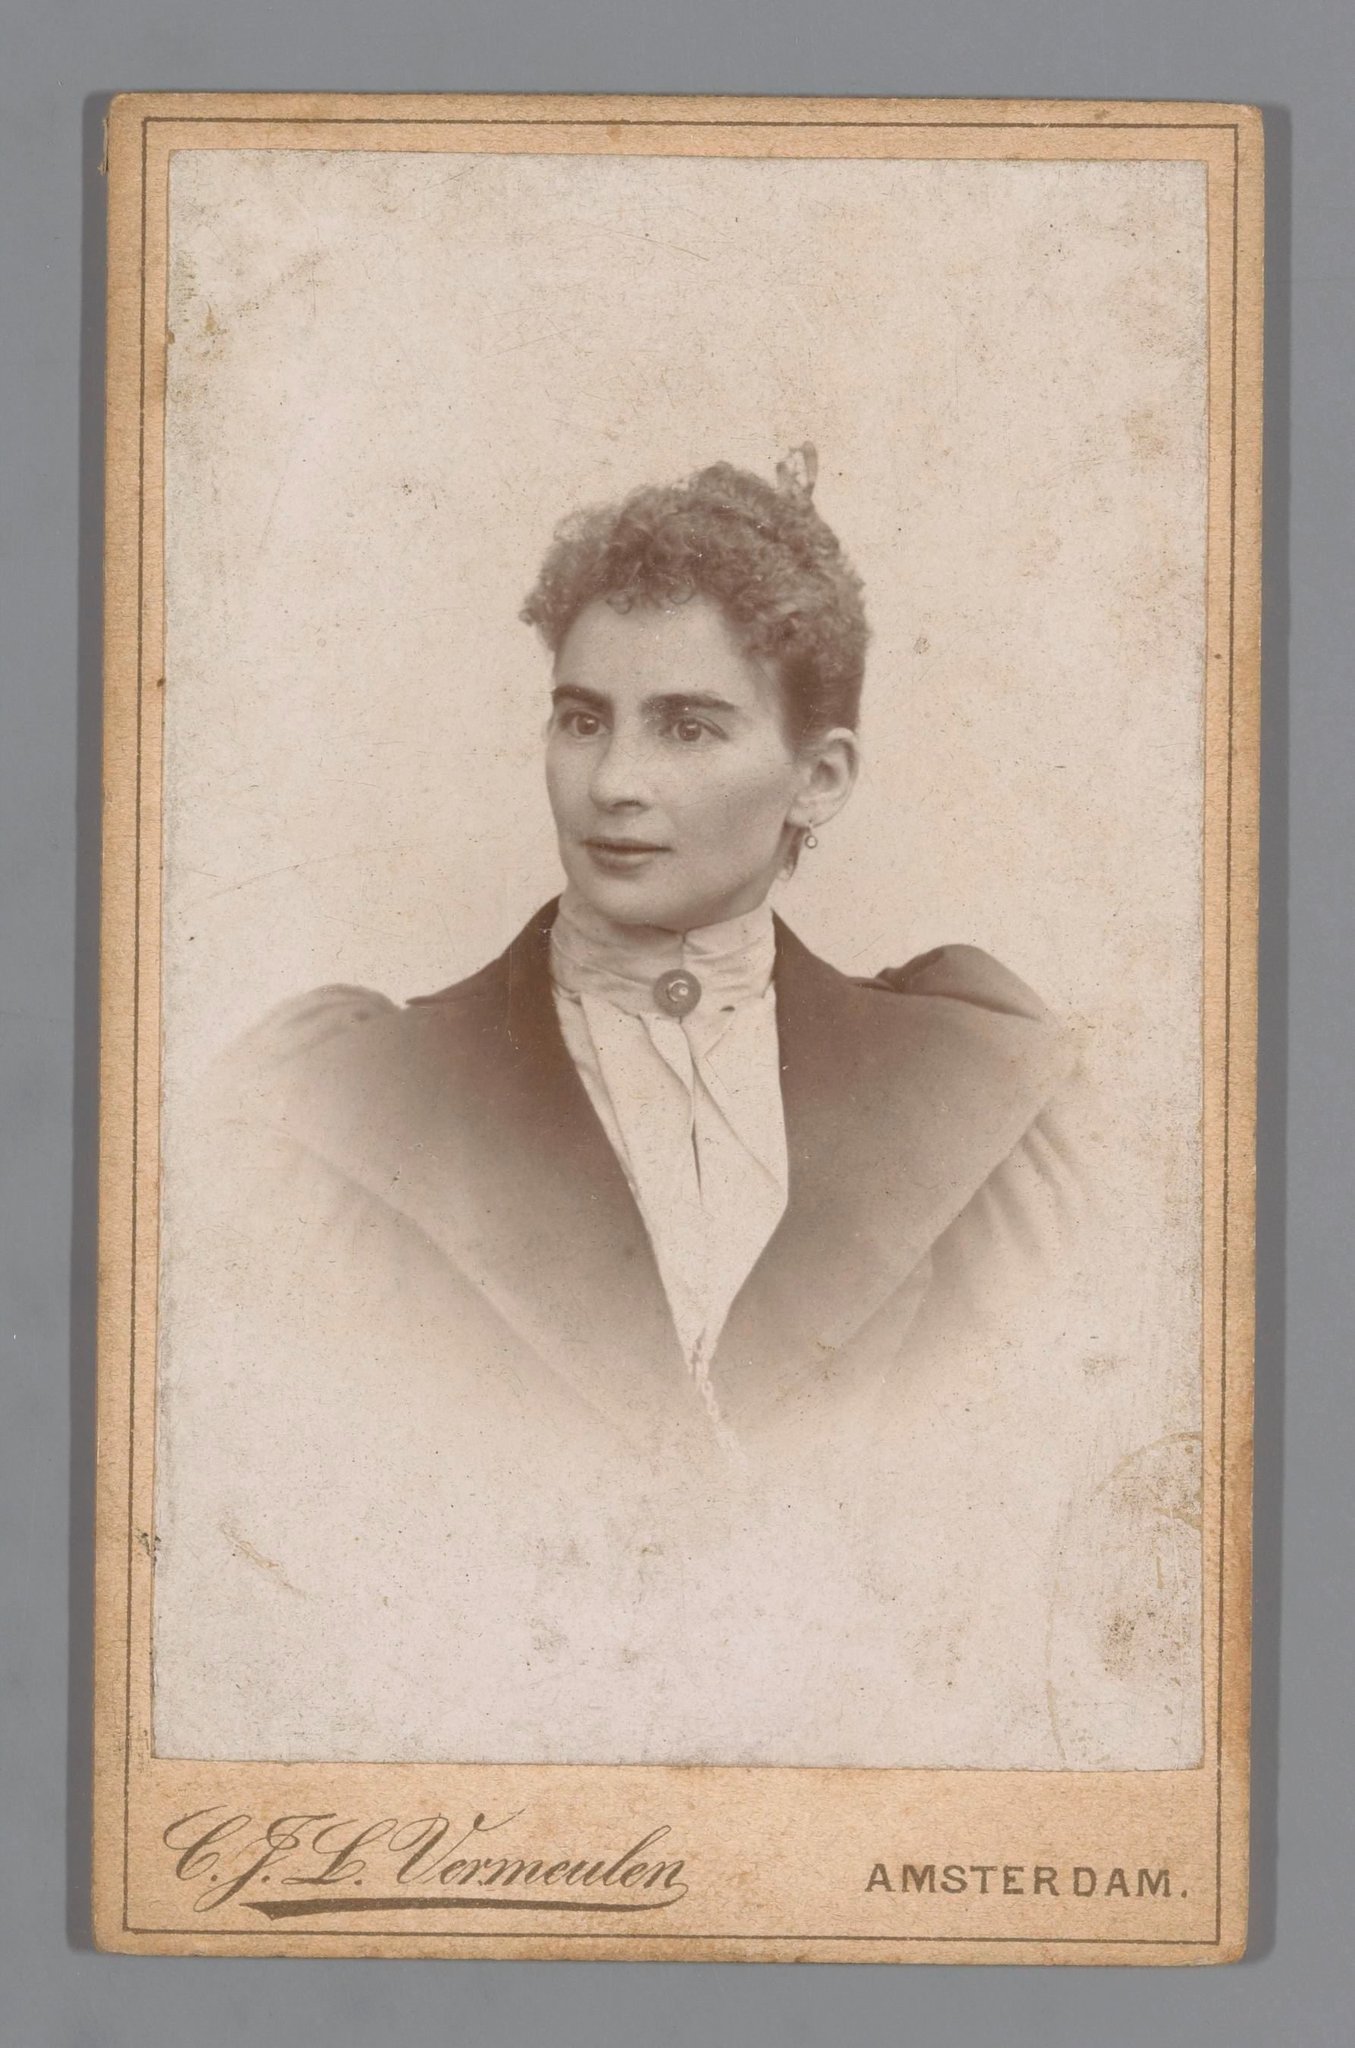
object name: photograph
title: Portret van een onbekende vrouw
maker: cornelis johannes lodewicus vermeulen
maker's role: fotograaf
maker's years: 1861-1936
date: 1888-1896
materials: cardboard, paper, photographic support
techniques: daylight paper print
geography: amsterdam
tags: adult woman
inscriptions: inscription: ‘Photographische Ateliers C.J.L Vermeulen Heerenstraat 6, & Heiligenweg hoek Singel Amsterdam. Specialiteit in vergrootingen.’, name: ‘C.J.L. Vermeulen Amsterdam.’